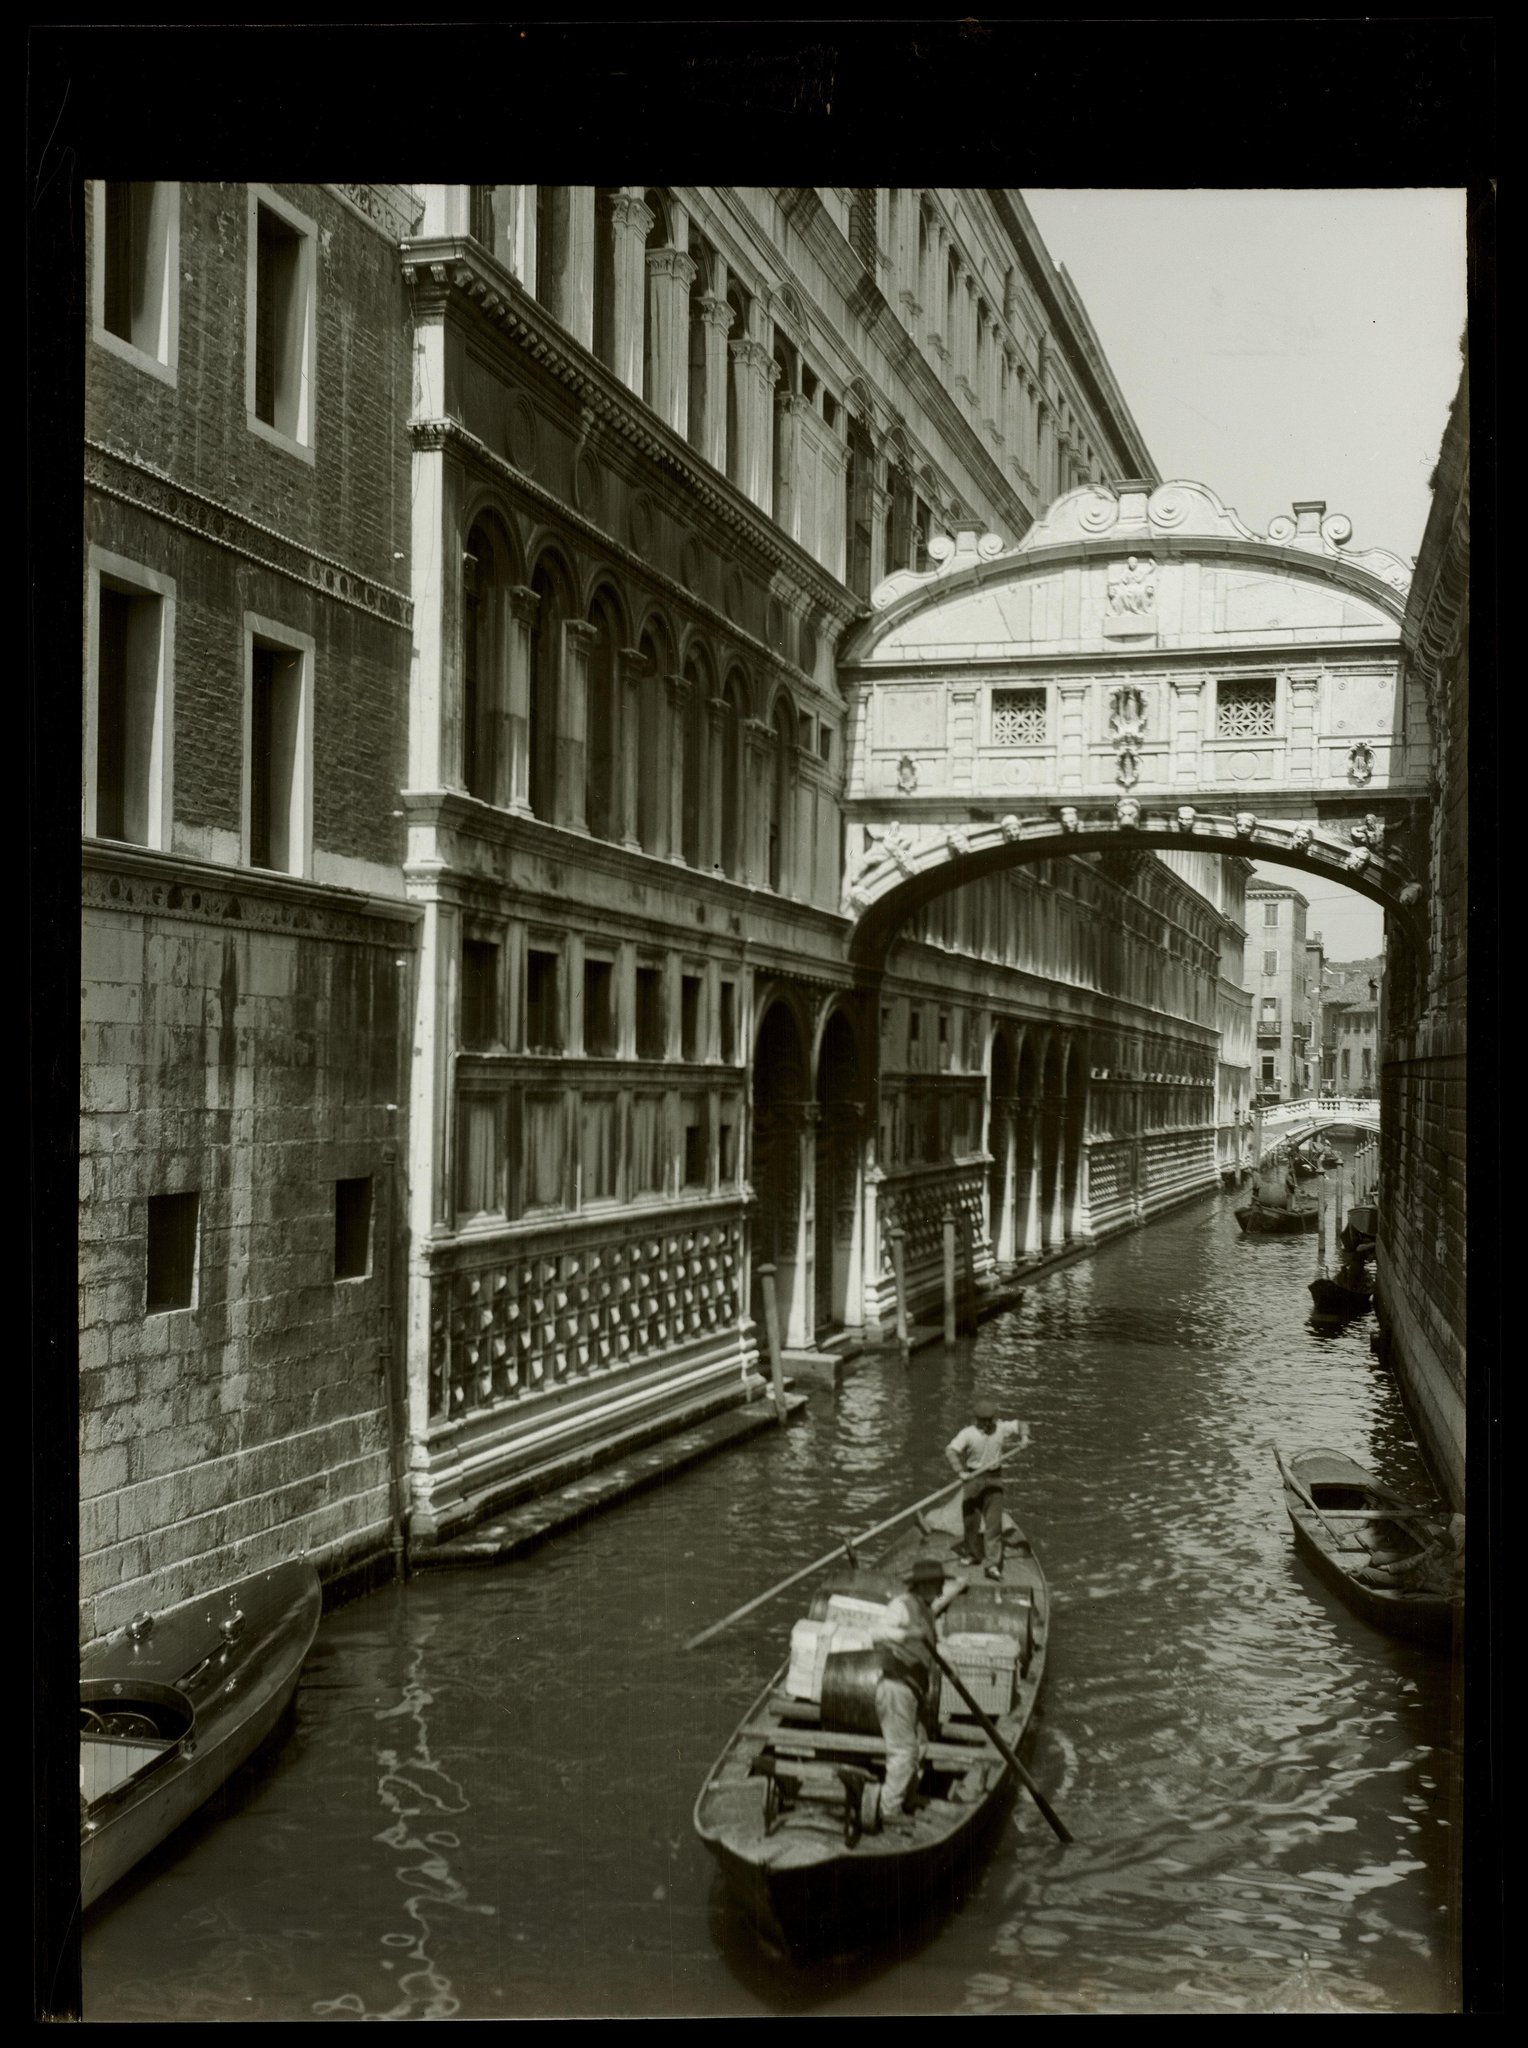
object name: negative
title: Filmnegatief met opname van Venetië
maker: Anonymous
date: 1907-1935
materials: film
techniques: gelatin silver negative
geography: venice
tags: venice